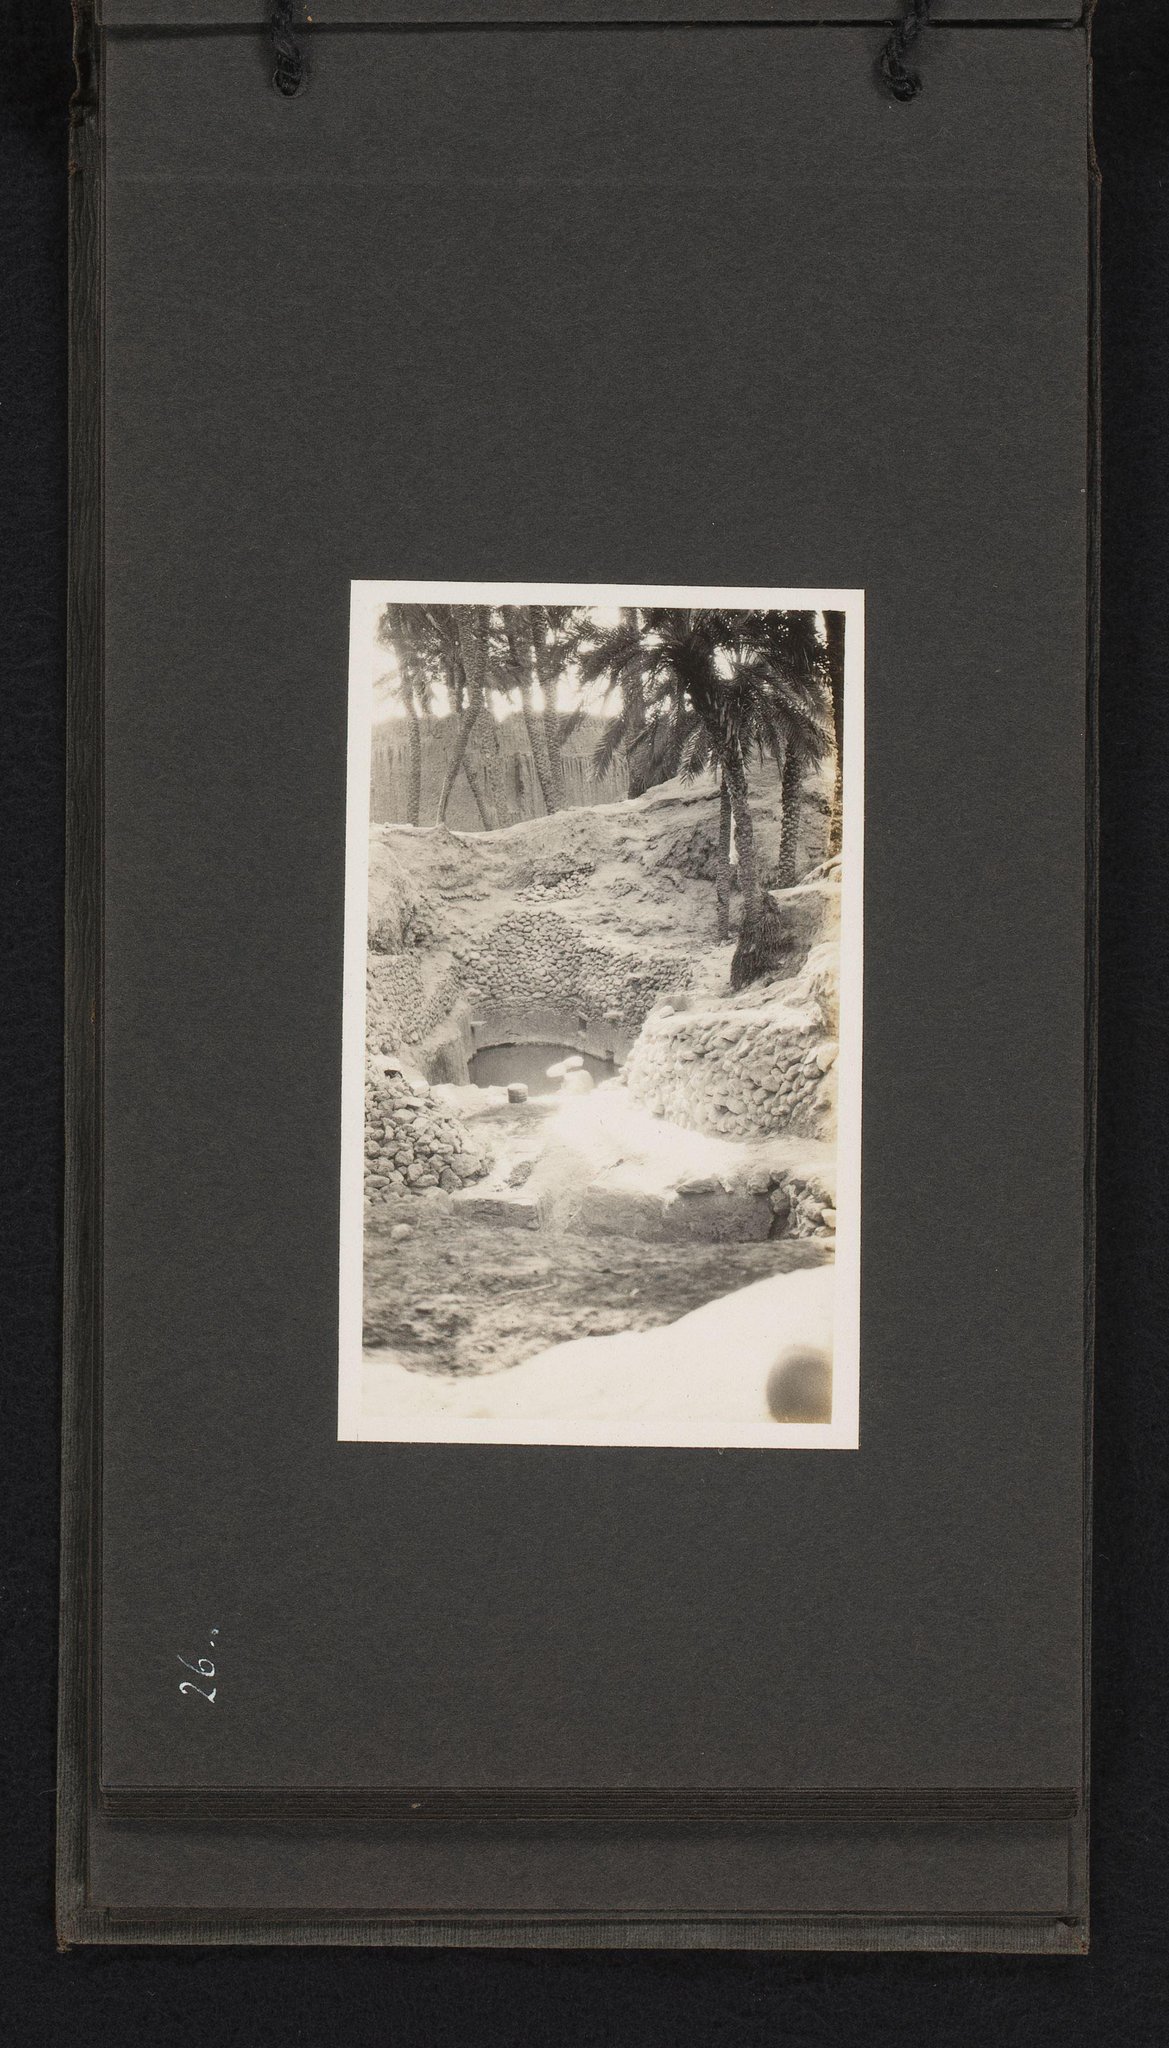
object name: album leaf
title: Wasgelegenheid in heuvelachtig landschap te Oudaghir, Le Figuig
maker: a.g.a. van eelde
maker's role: engineer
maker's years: 1862-1950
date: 1927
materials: paper, photographic support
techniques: gelatin silver print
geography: morocco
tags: trees: palm-tree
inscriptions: number: ‘26.’